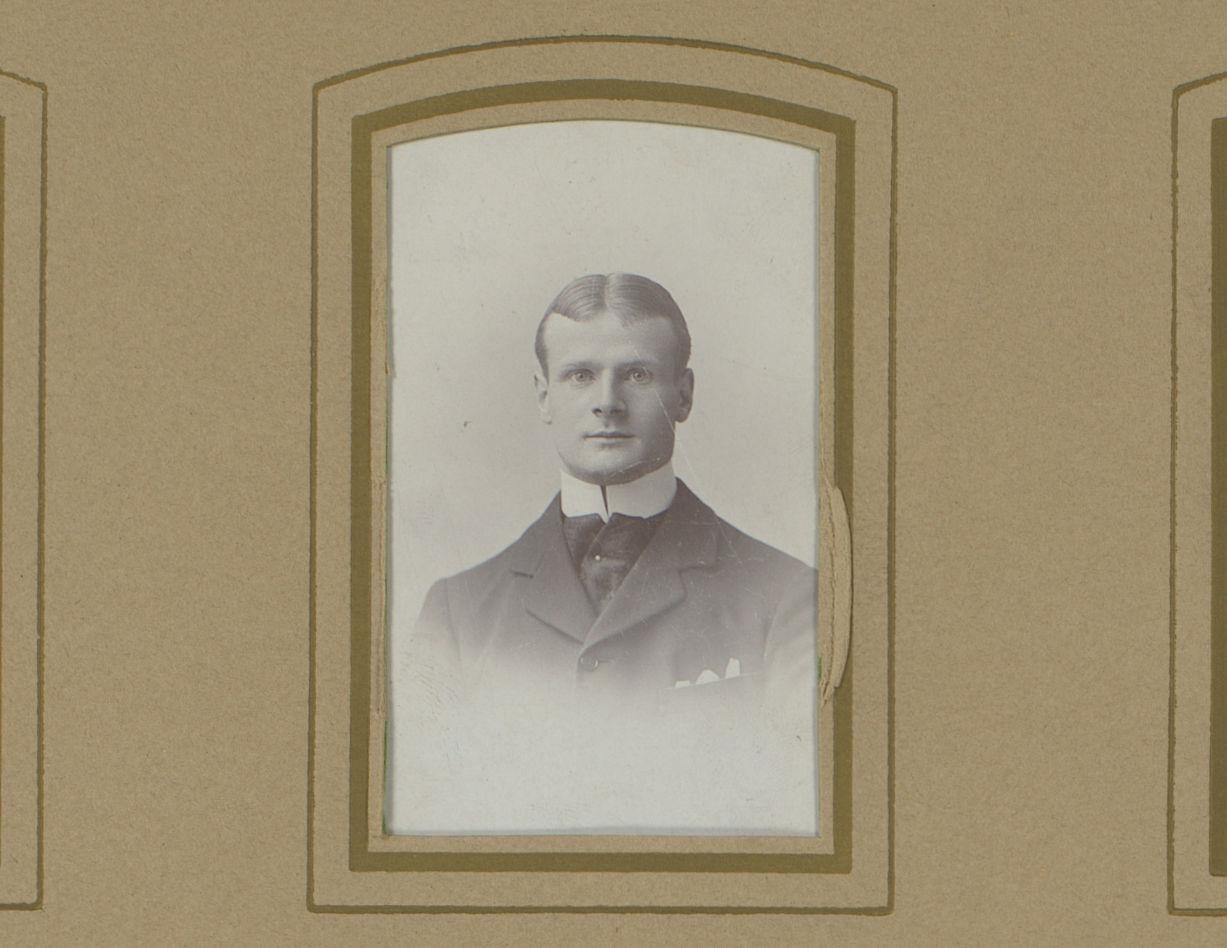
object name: album leaf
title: Portret van een man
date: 1894-1907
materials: cardboard, photographic support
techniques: matte daylight collodion silver print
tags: historical persons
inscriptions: inscription: ‘[Koene & Büttinghausen]/ Amsterdam/ Heerengracht [150.]/ TELEPHOONNUMMER 1402/ Batavia.’